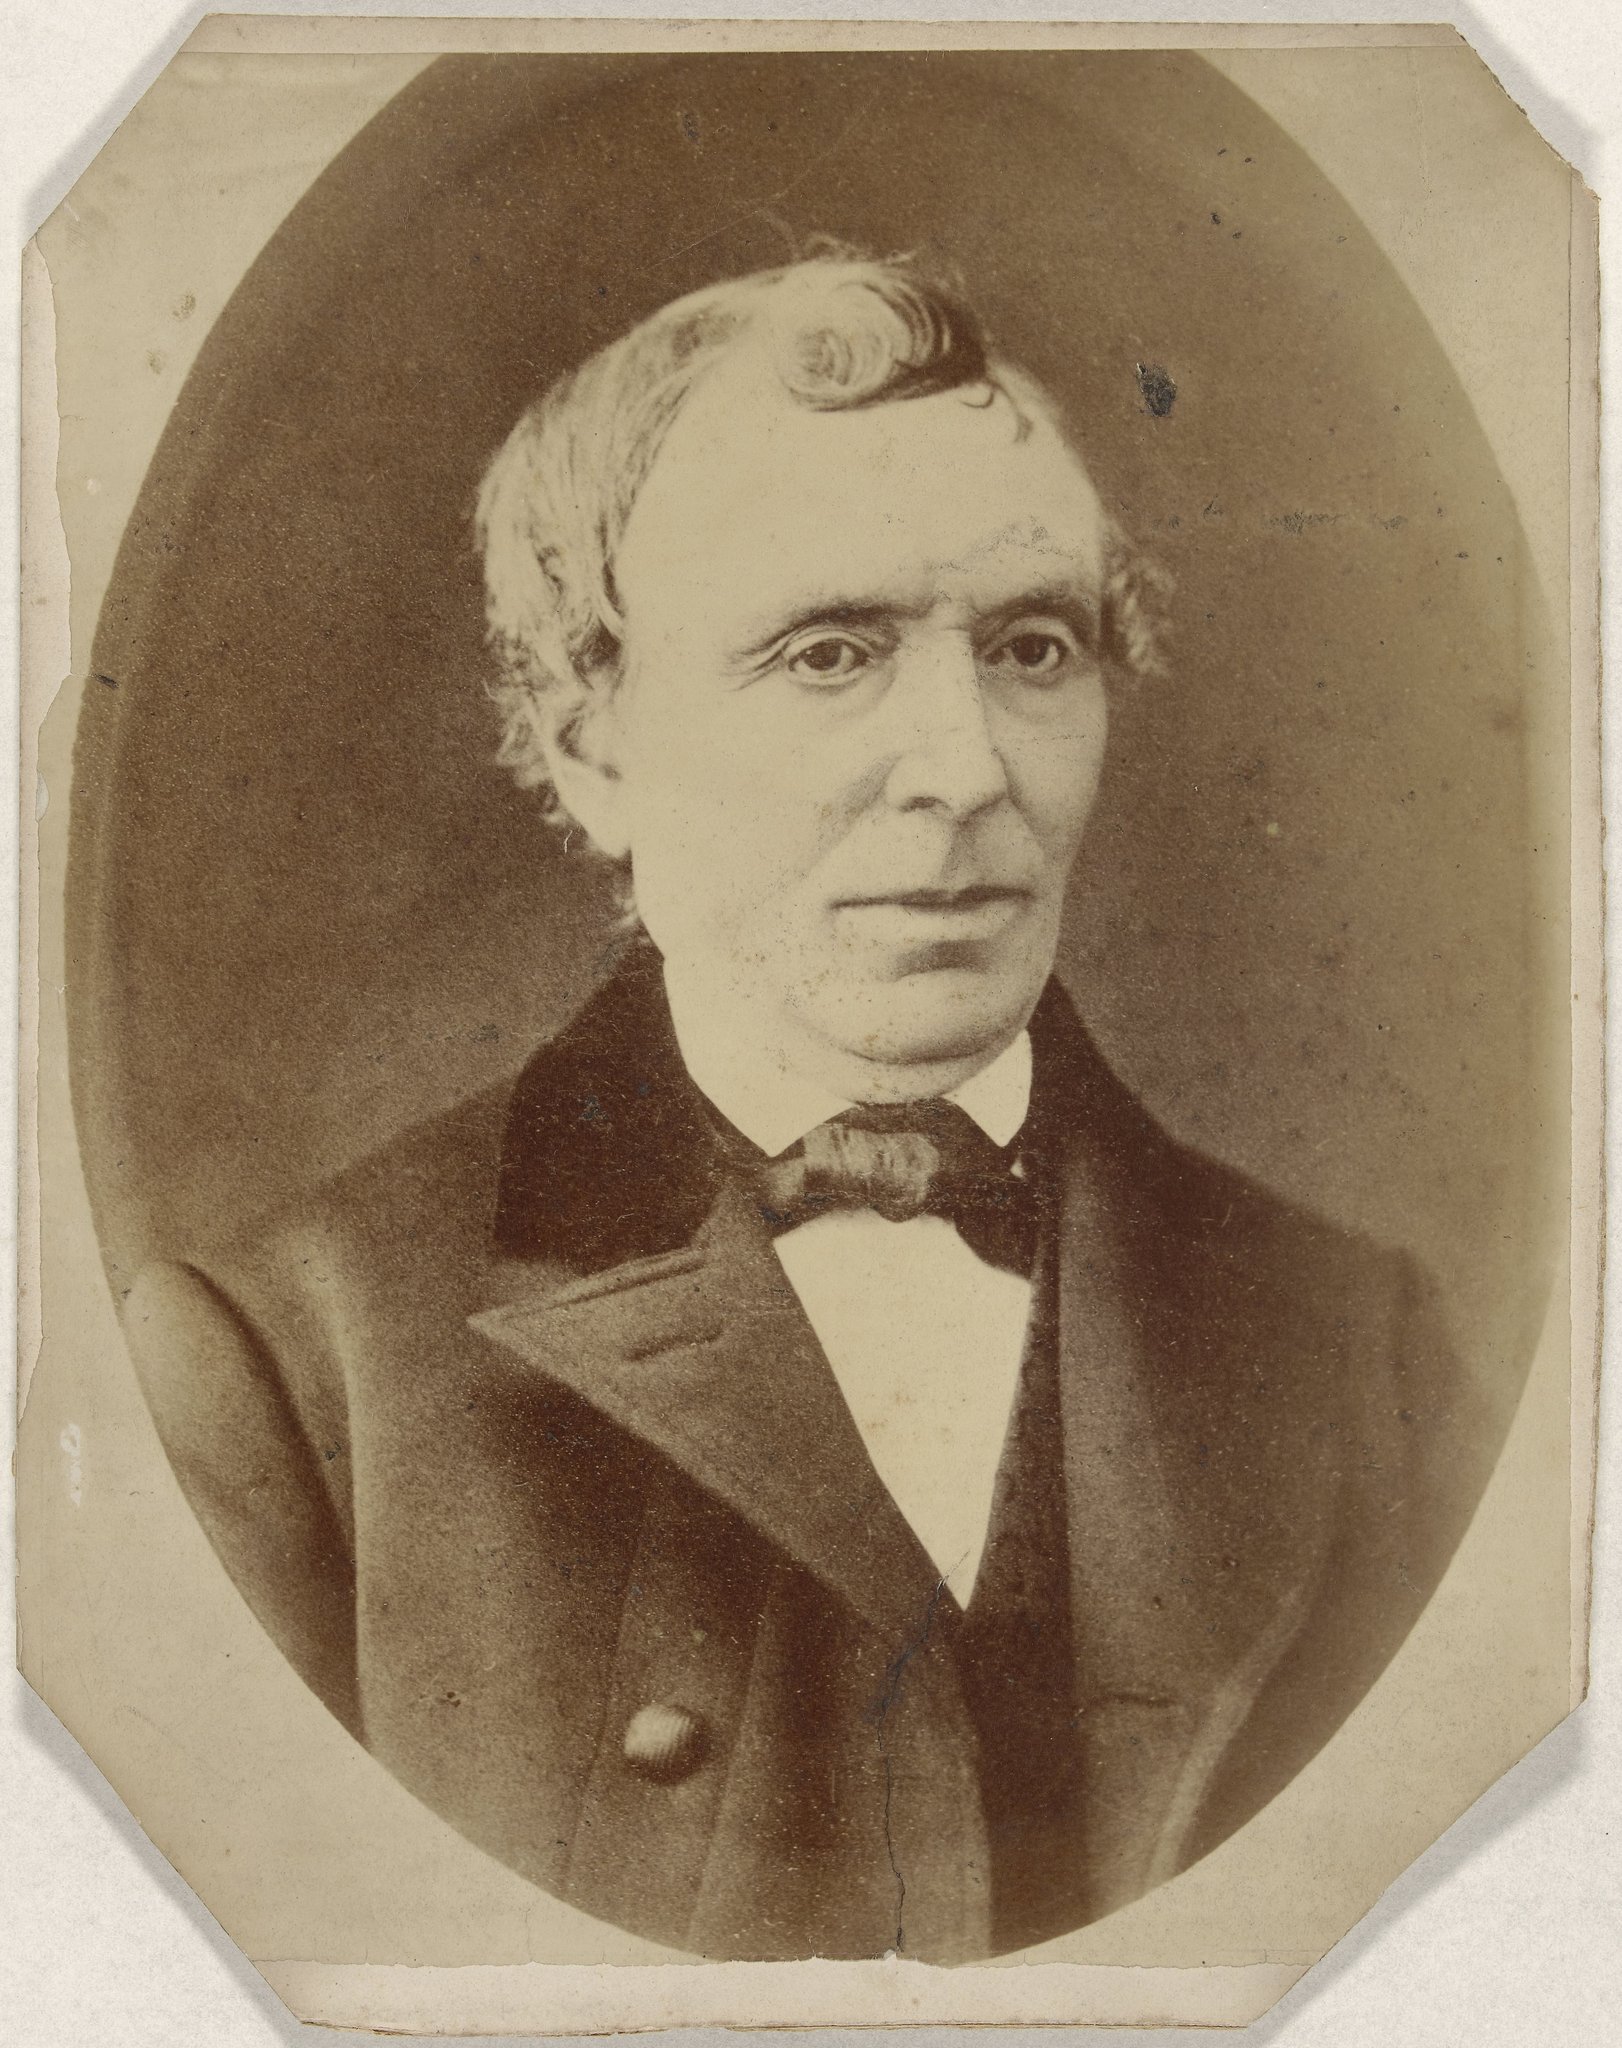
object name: photograph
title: Portret van een schilderij van een man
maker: Anonymous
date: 1890-1910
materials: photographic support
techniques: albumen print